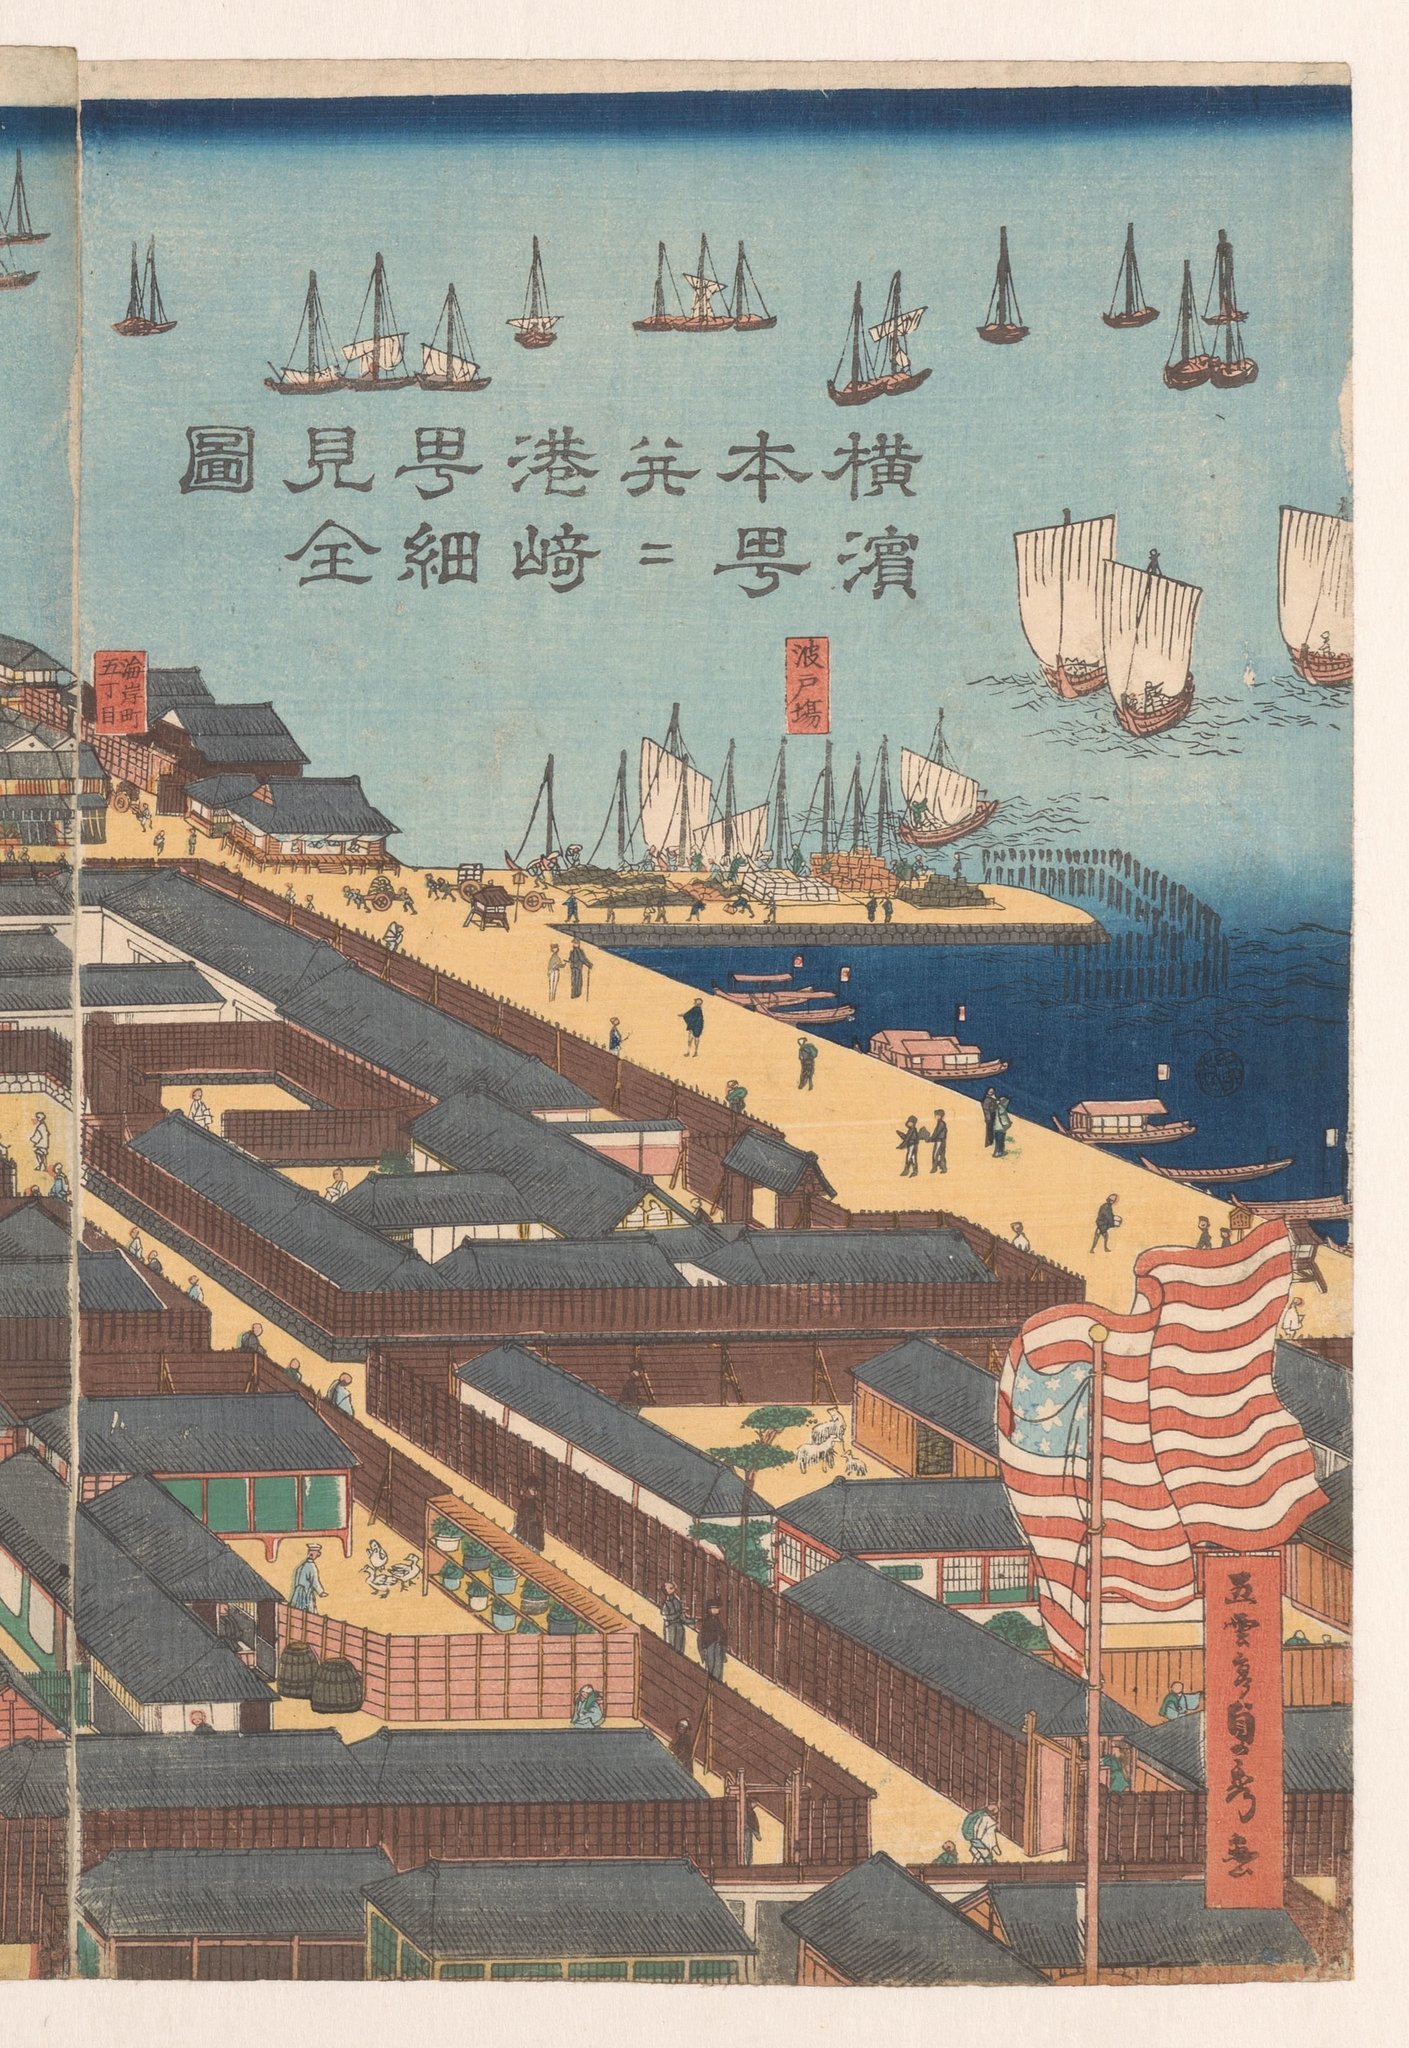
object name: print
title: Overzicht van de wijk Honcho en het Miyozaki kwartier in Yokohama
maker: utagawa sadahide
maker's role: draughtsman, print maker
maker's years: 1807-1873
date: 1804-1860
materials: paper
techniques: woodcut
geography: japan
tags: harbour, city-view in general; 'veduta'